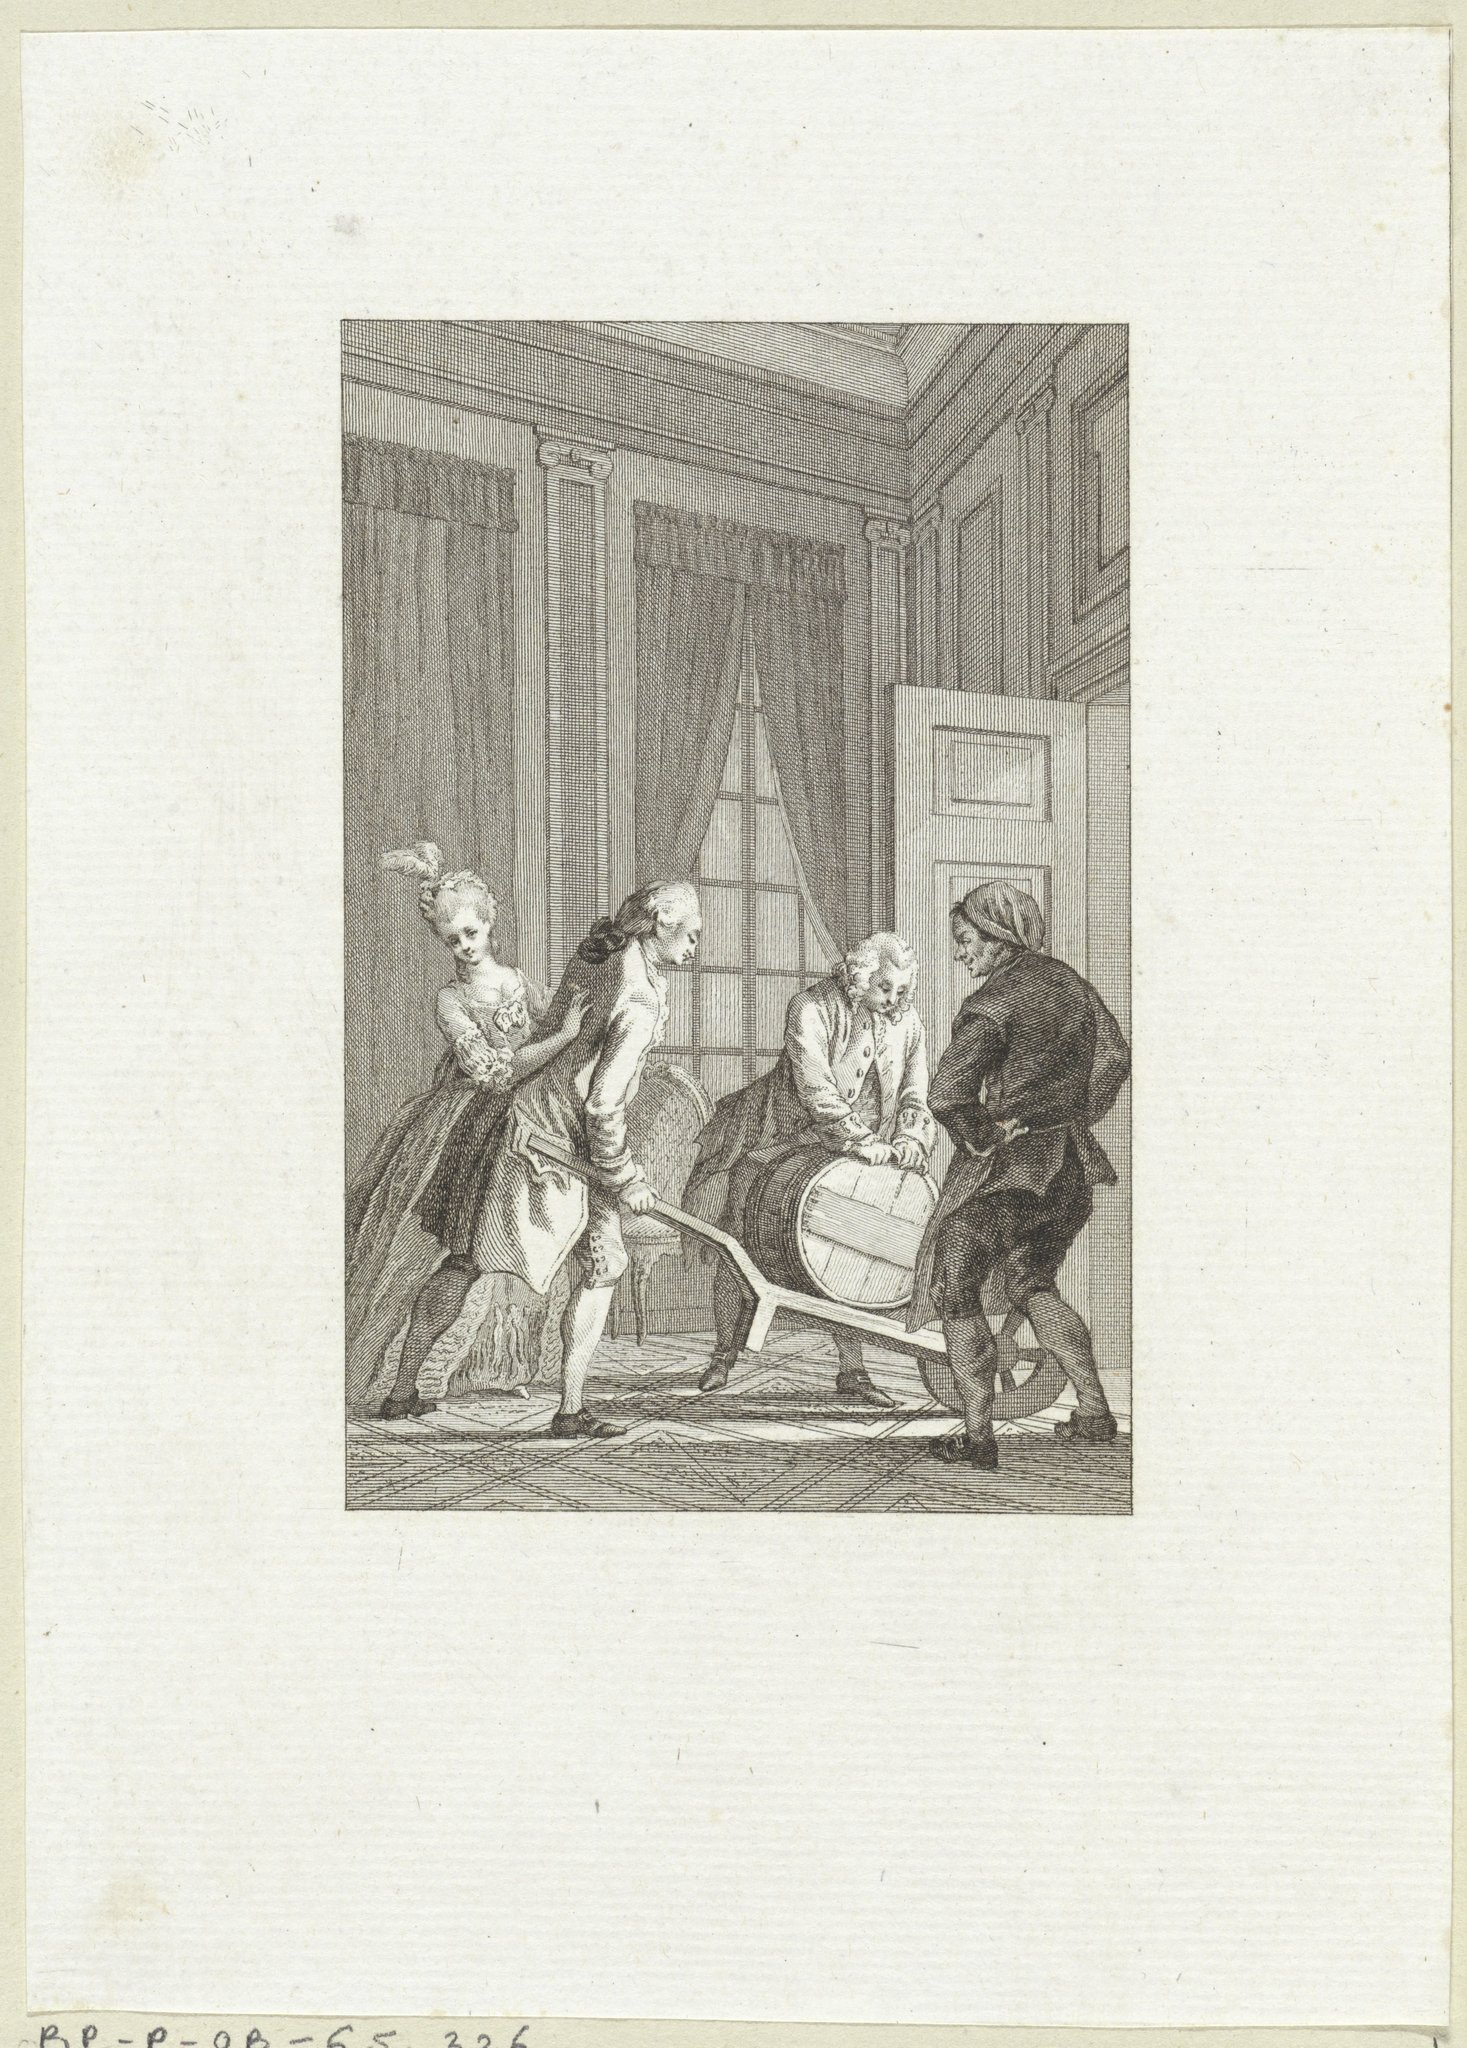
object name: print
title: In een vertrek staat een man met een kruiwagen waarop een ton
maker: reinier vinkeles (i)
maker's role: draughtsman, print maker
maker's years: 1741-1816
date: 1777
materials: paper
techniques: engraving, etching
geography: amsterdam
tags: wooden container: barrel, cask, bucket, wheelbarrow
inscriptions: collector's mark: Lugt 240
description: Proefdruk van illustratie die mogelijk is gebruikt in: Mercier, Louis-Sébastien. De Kruiwagen van den Azijnverkooper. Amsterdam, 1777.